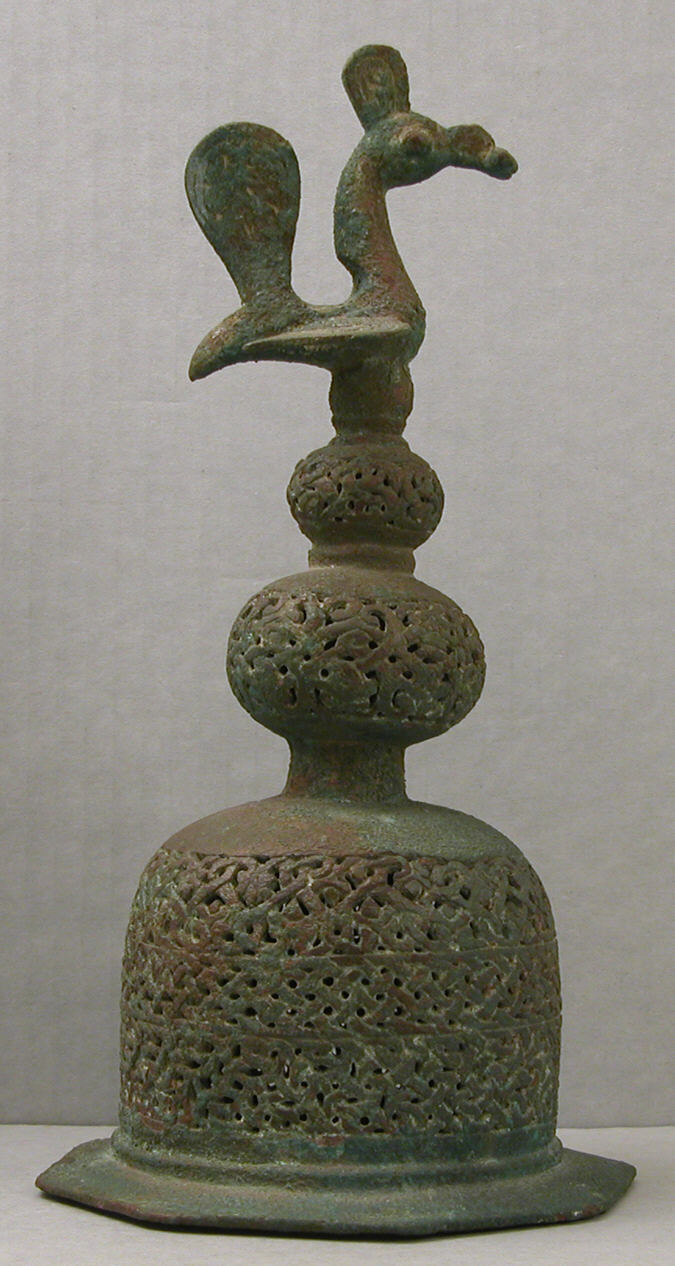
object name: finial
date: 1101-1200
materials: bronze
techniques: casting, engraving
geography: iran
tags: birds